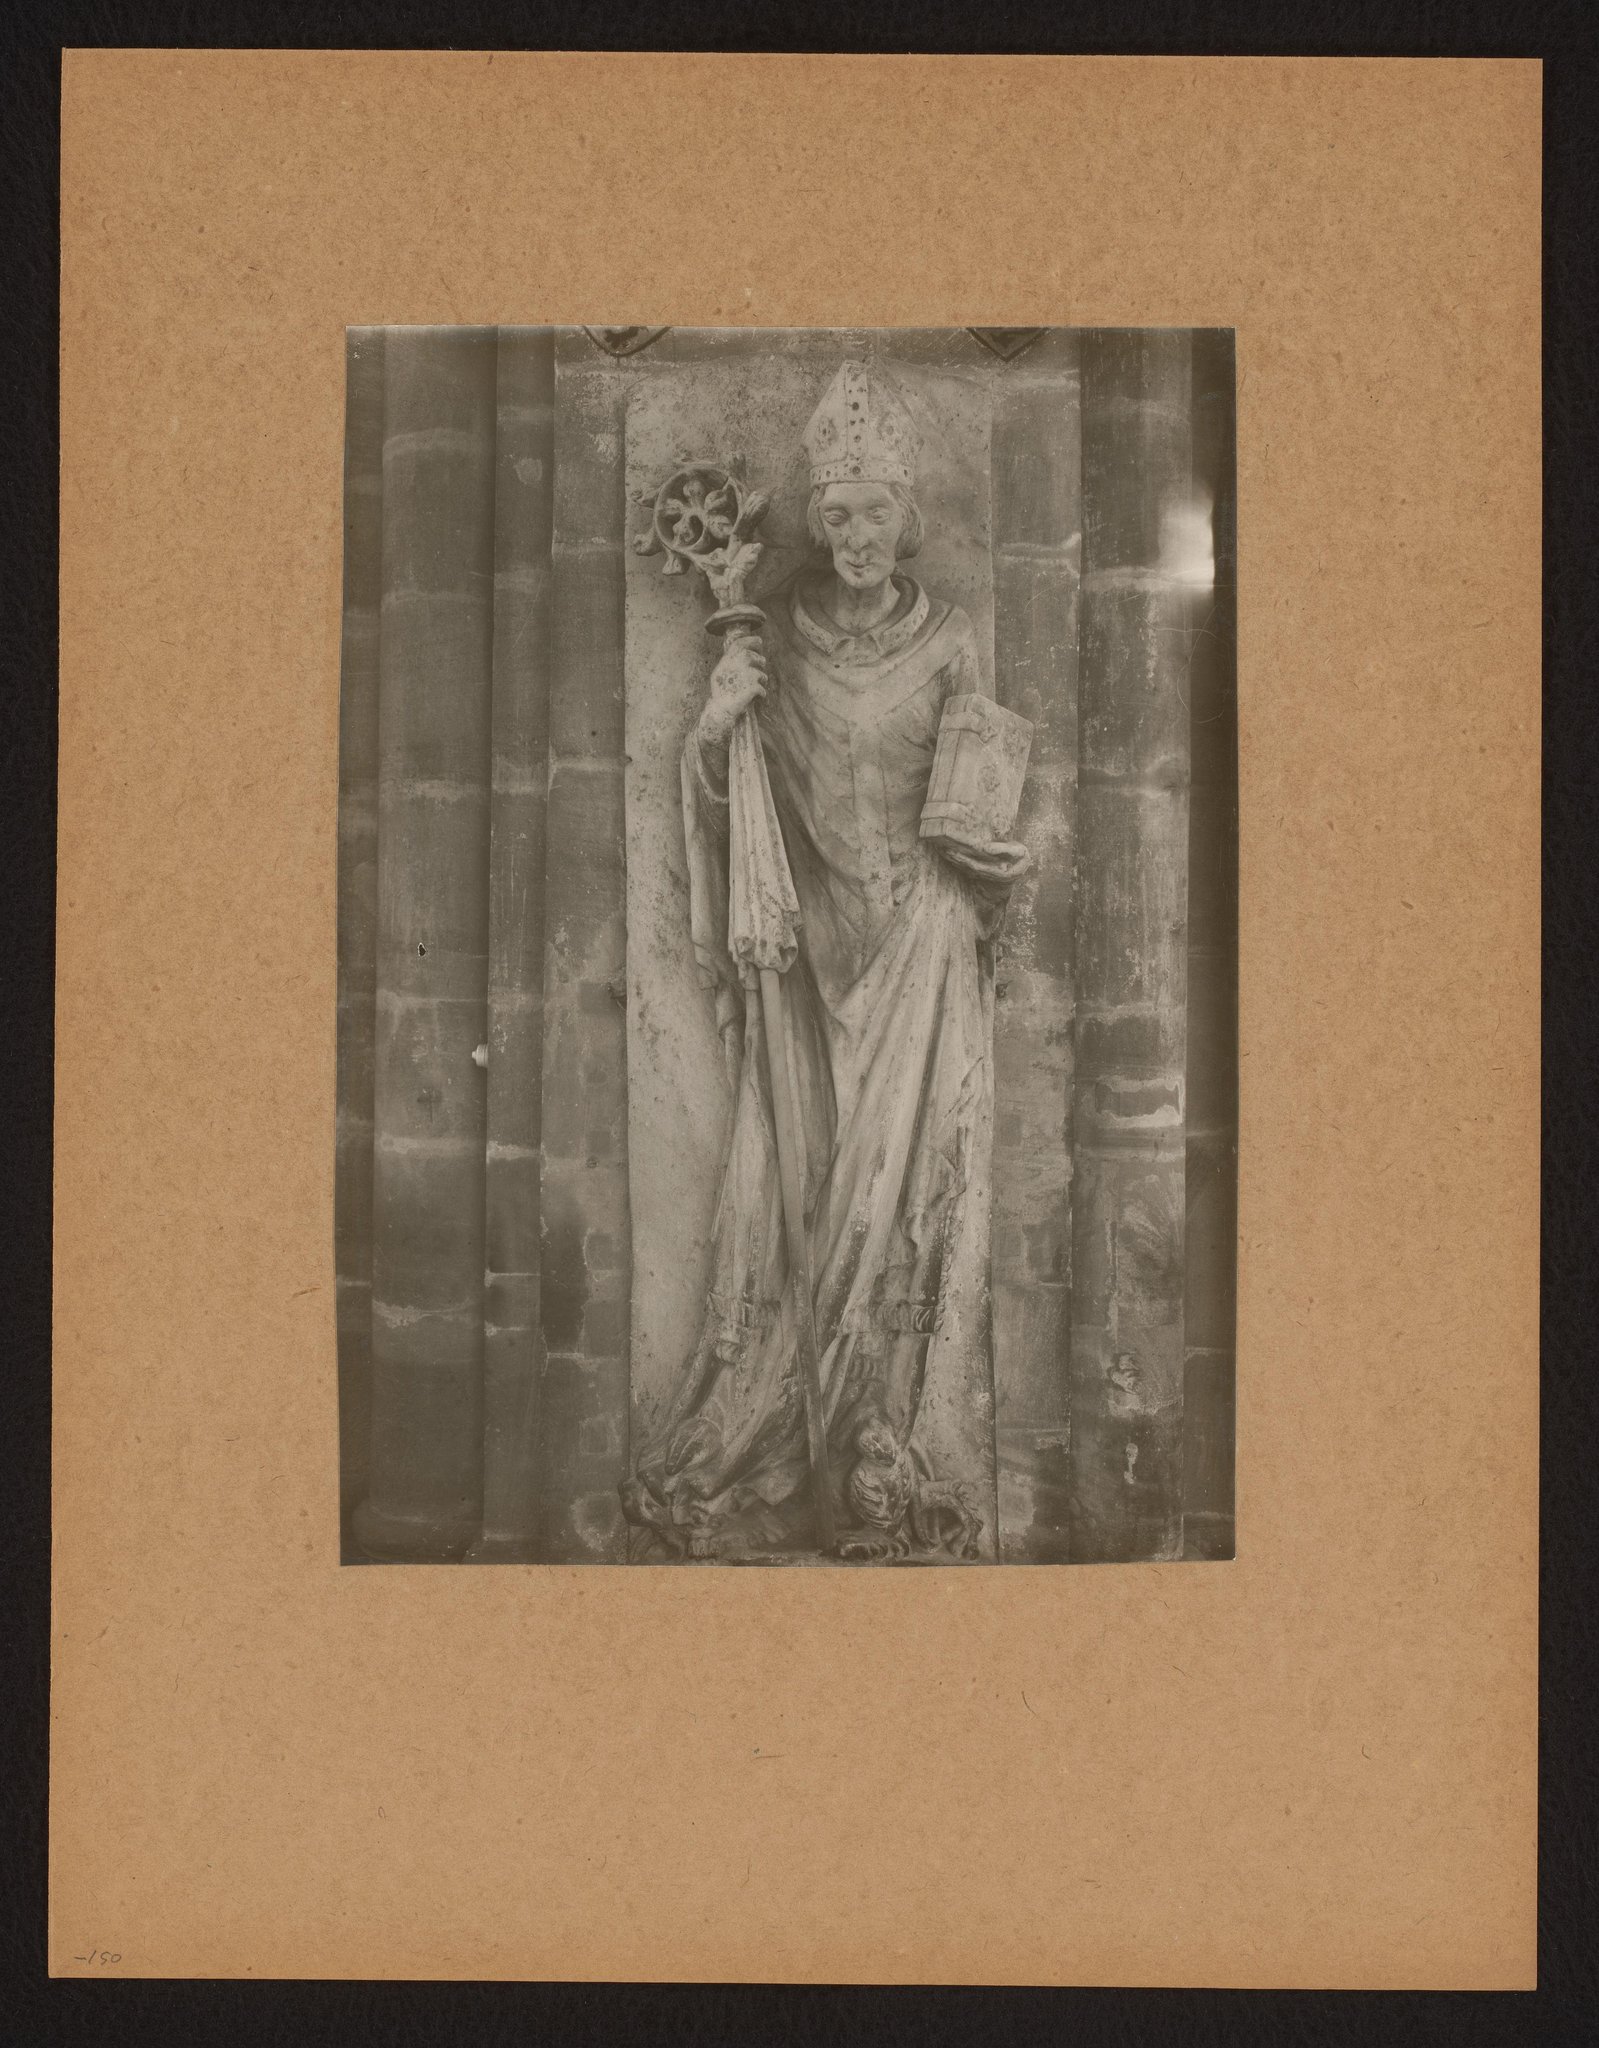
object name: album leaf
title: Kreuzgang, Grabmal Friedrich v.Hohenlohe + 1352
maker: Anonymous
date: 1900-1920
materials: paper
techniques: gelatin silver print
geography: bamberg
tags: interior of church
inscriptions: number: ‘153.’